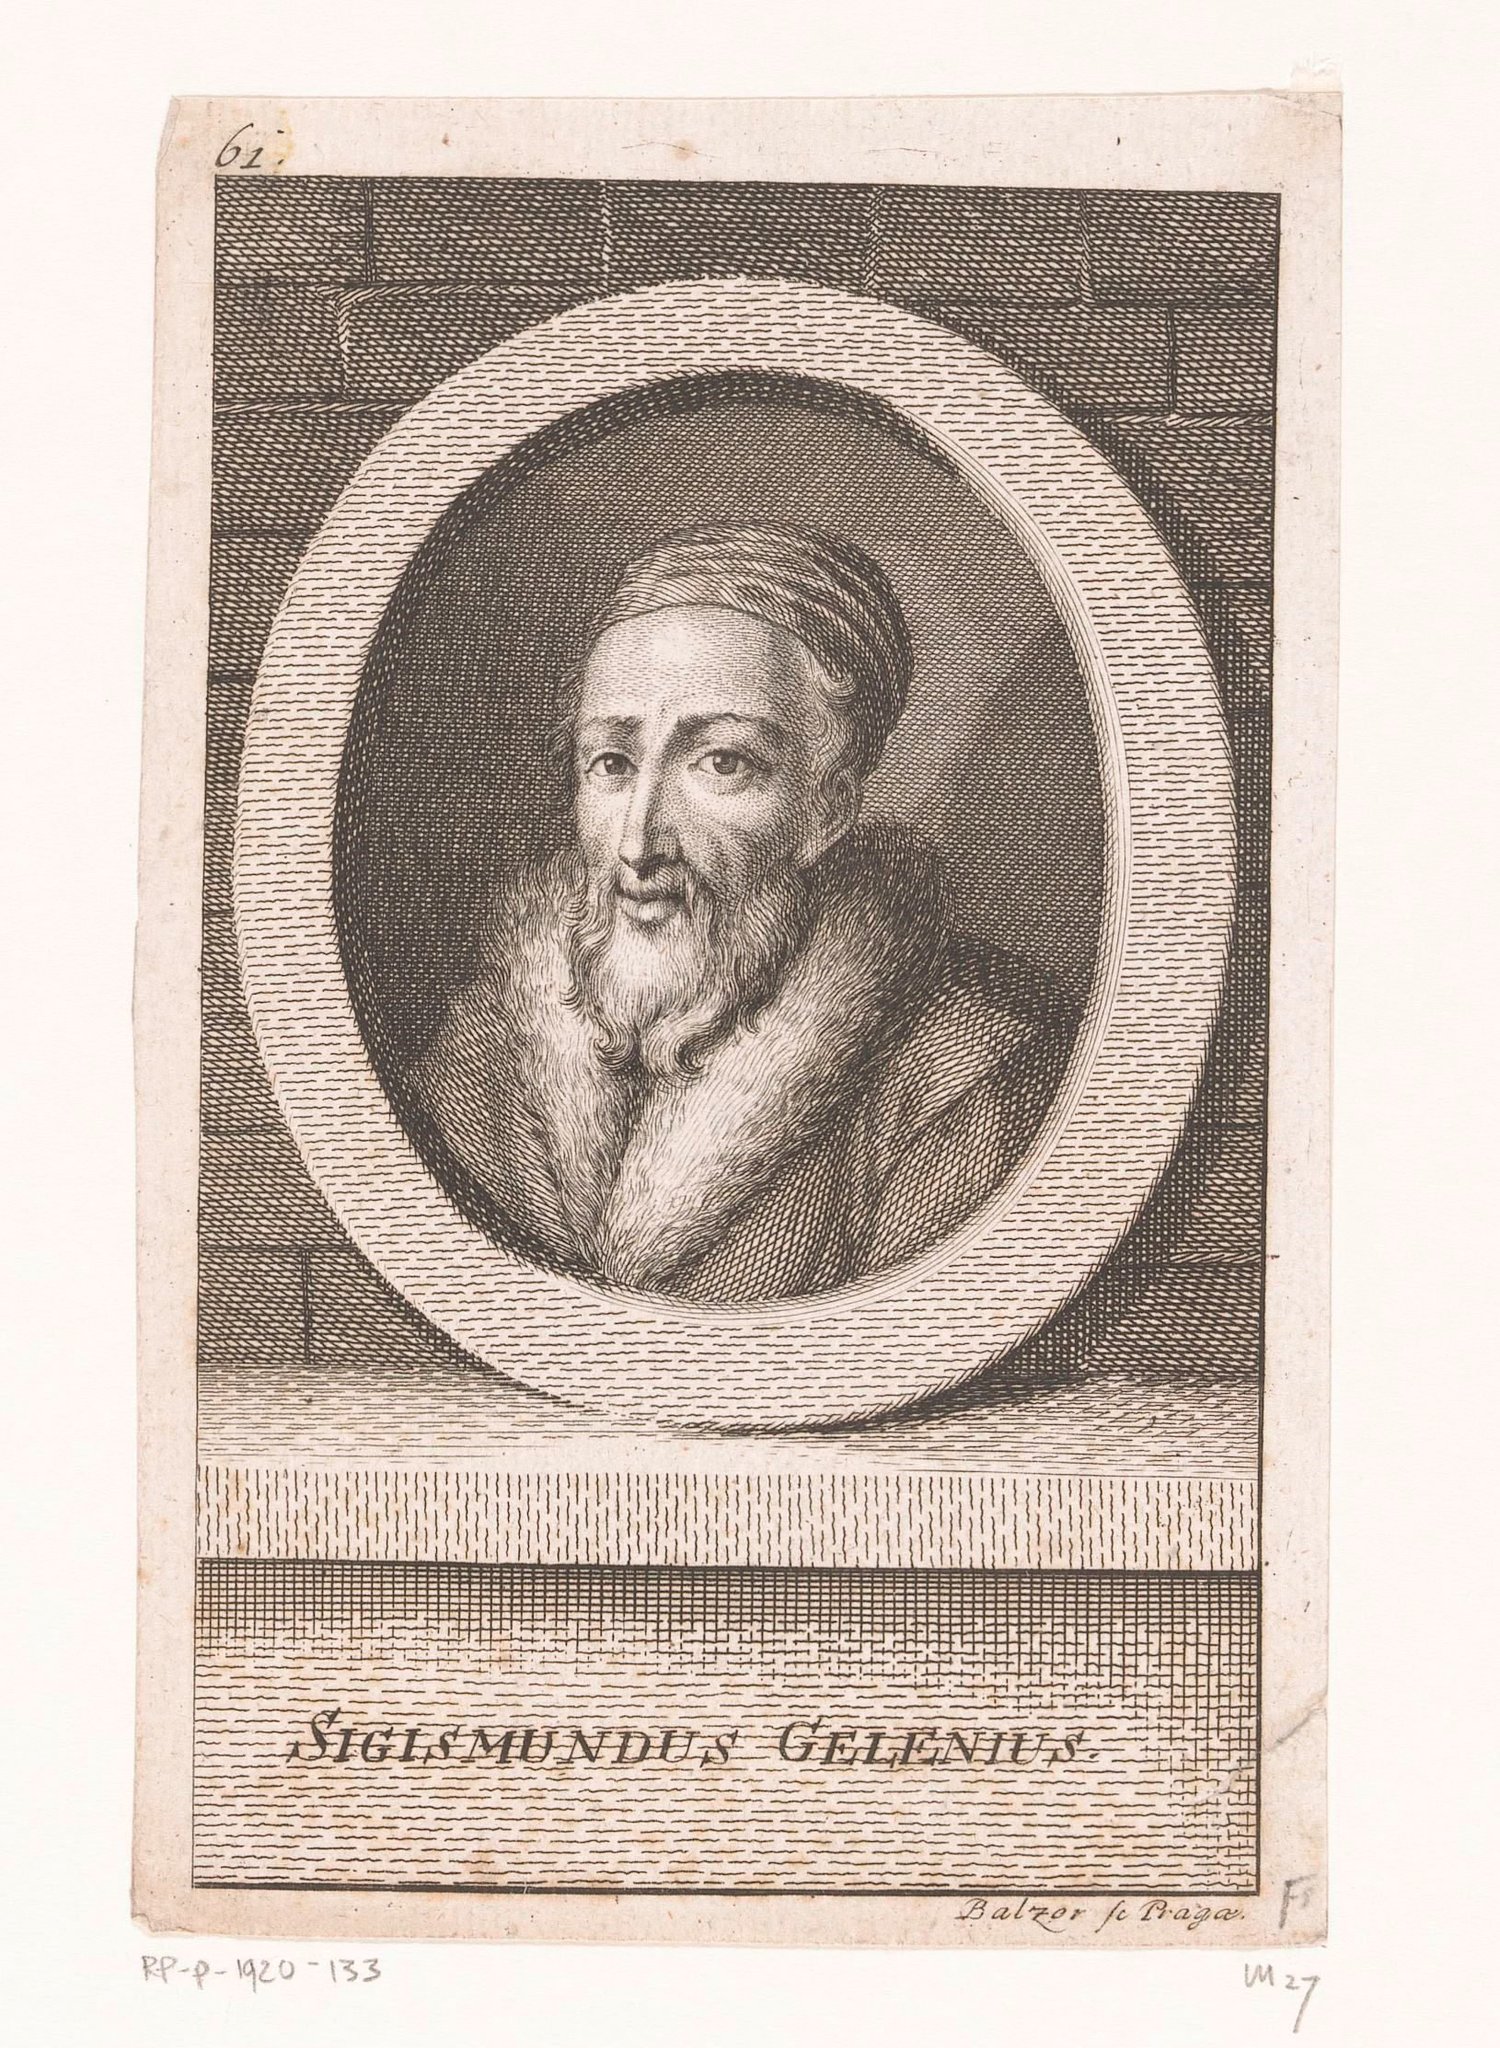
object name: print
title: Sigismundus Gelenius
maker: jan balzer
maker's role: print maker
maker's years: 1736-1799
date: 1746-1799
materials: paper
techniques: engraving, etching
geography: prague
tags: prague, historical persons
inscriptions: collector's mark: Lugt 2228